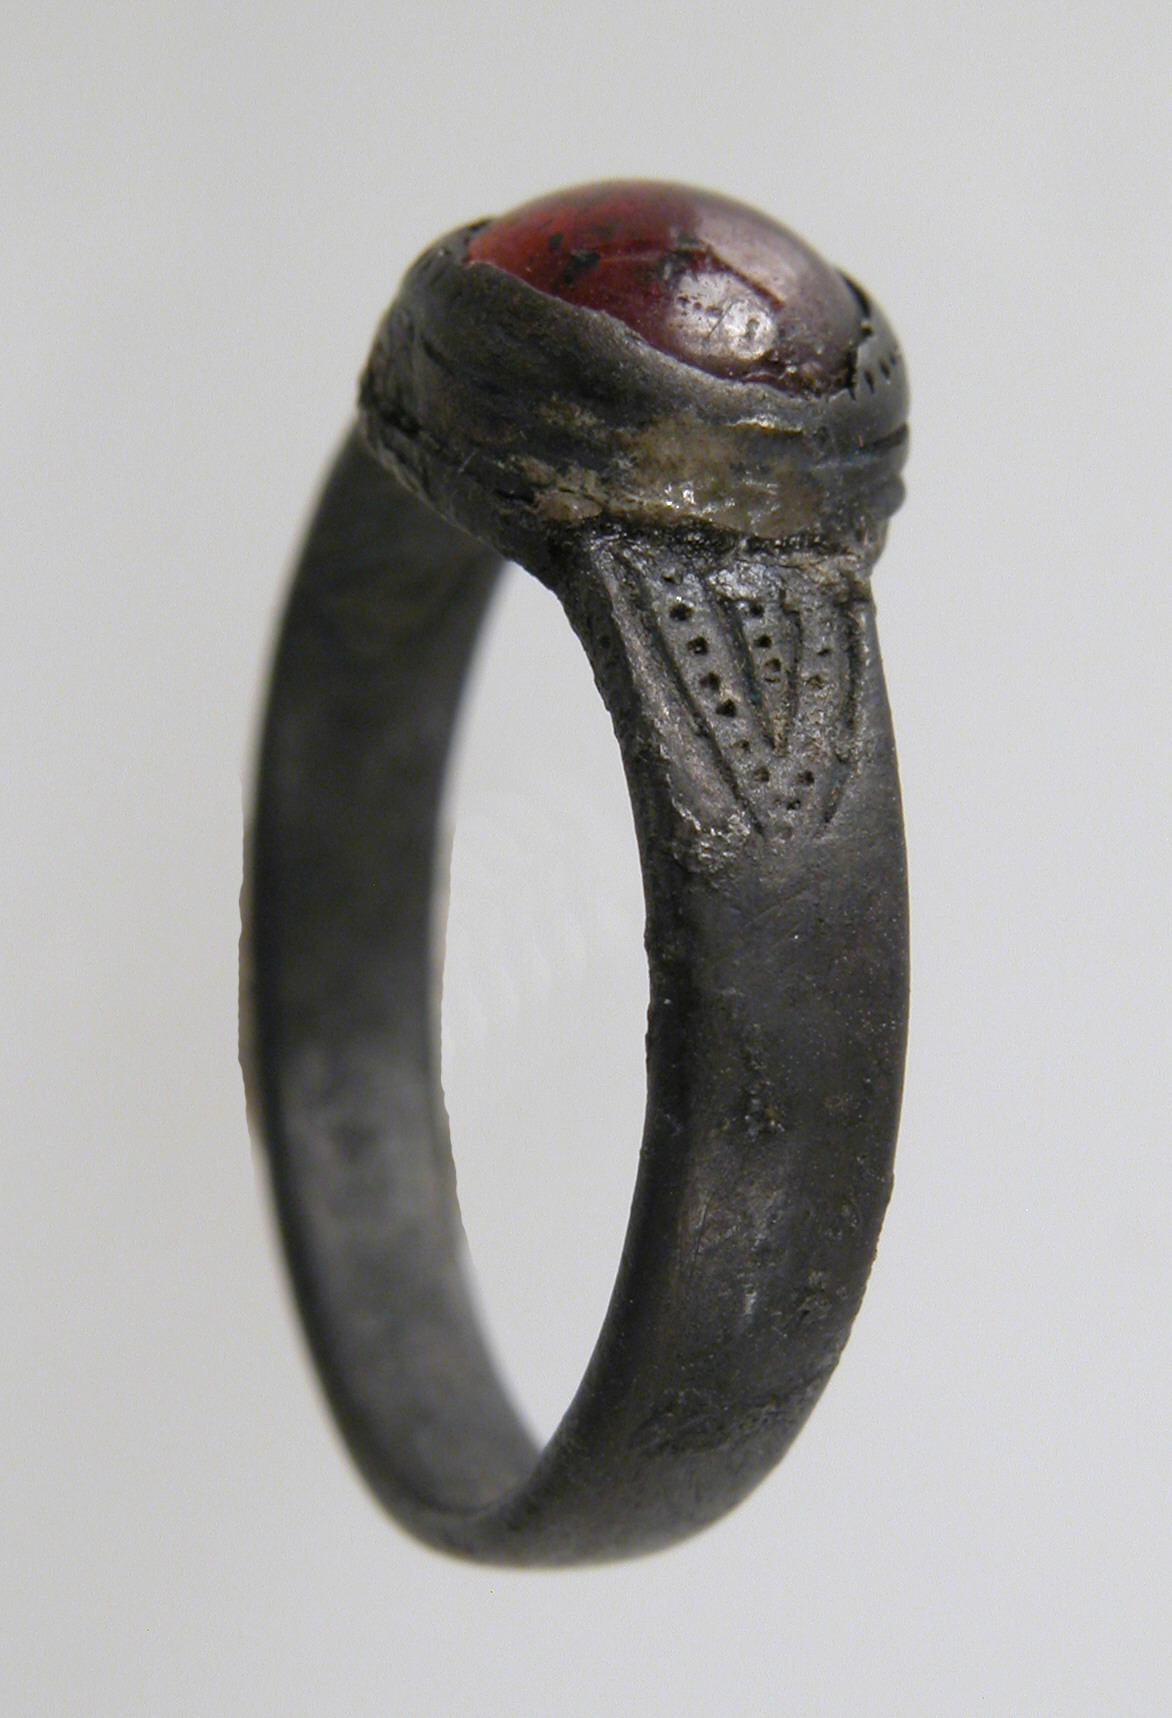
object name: ring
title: Finger Ring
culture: frankish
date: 601-700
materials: gemstone, glass, paste, silver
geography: northern france